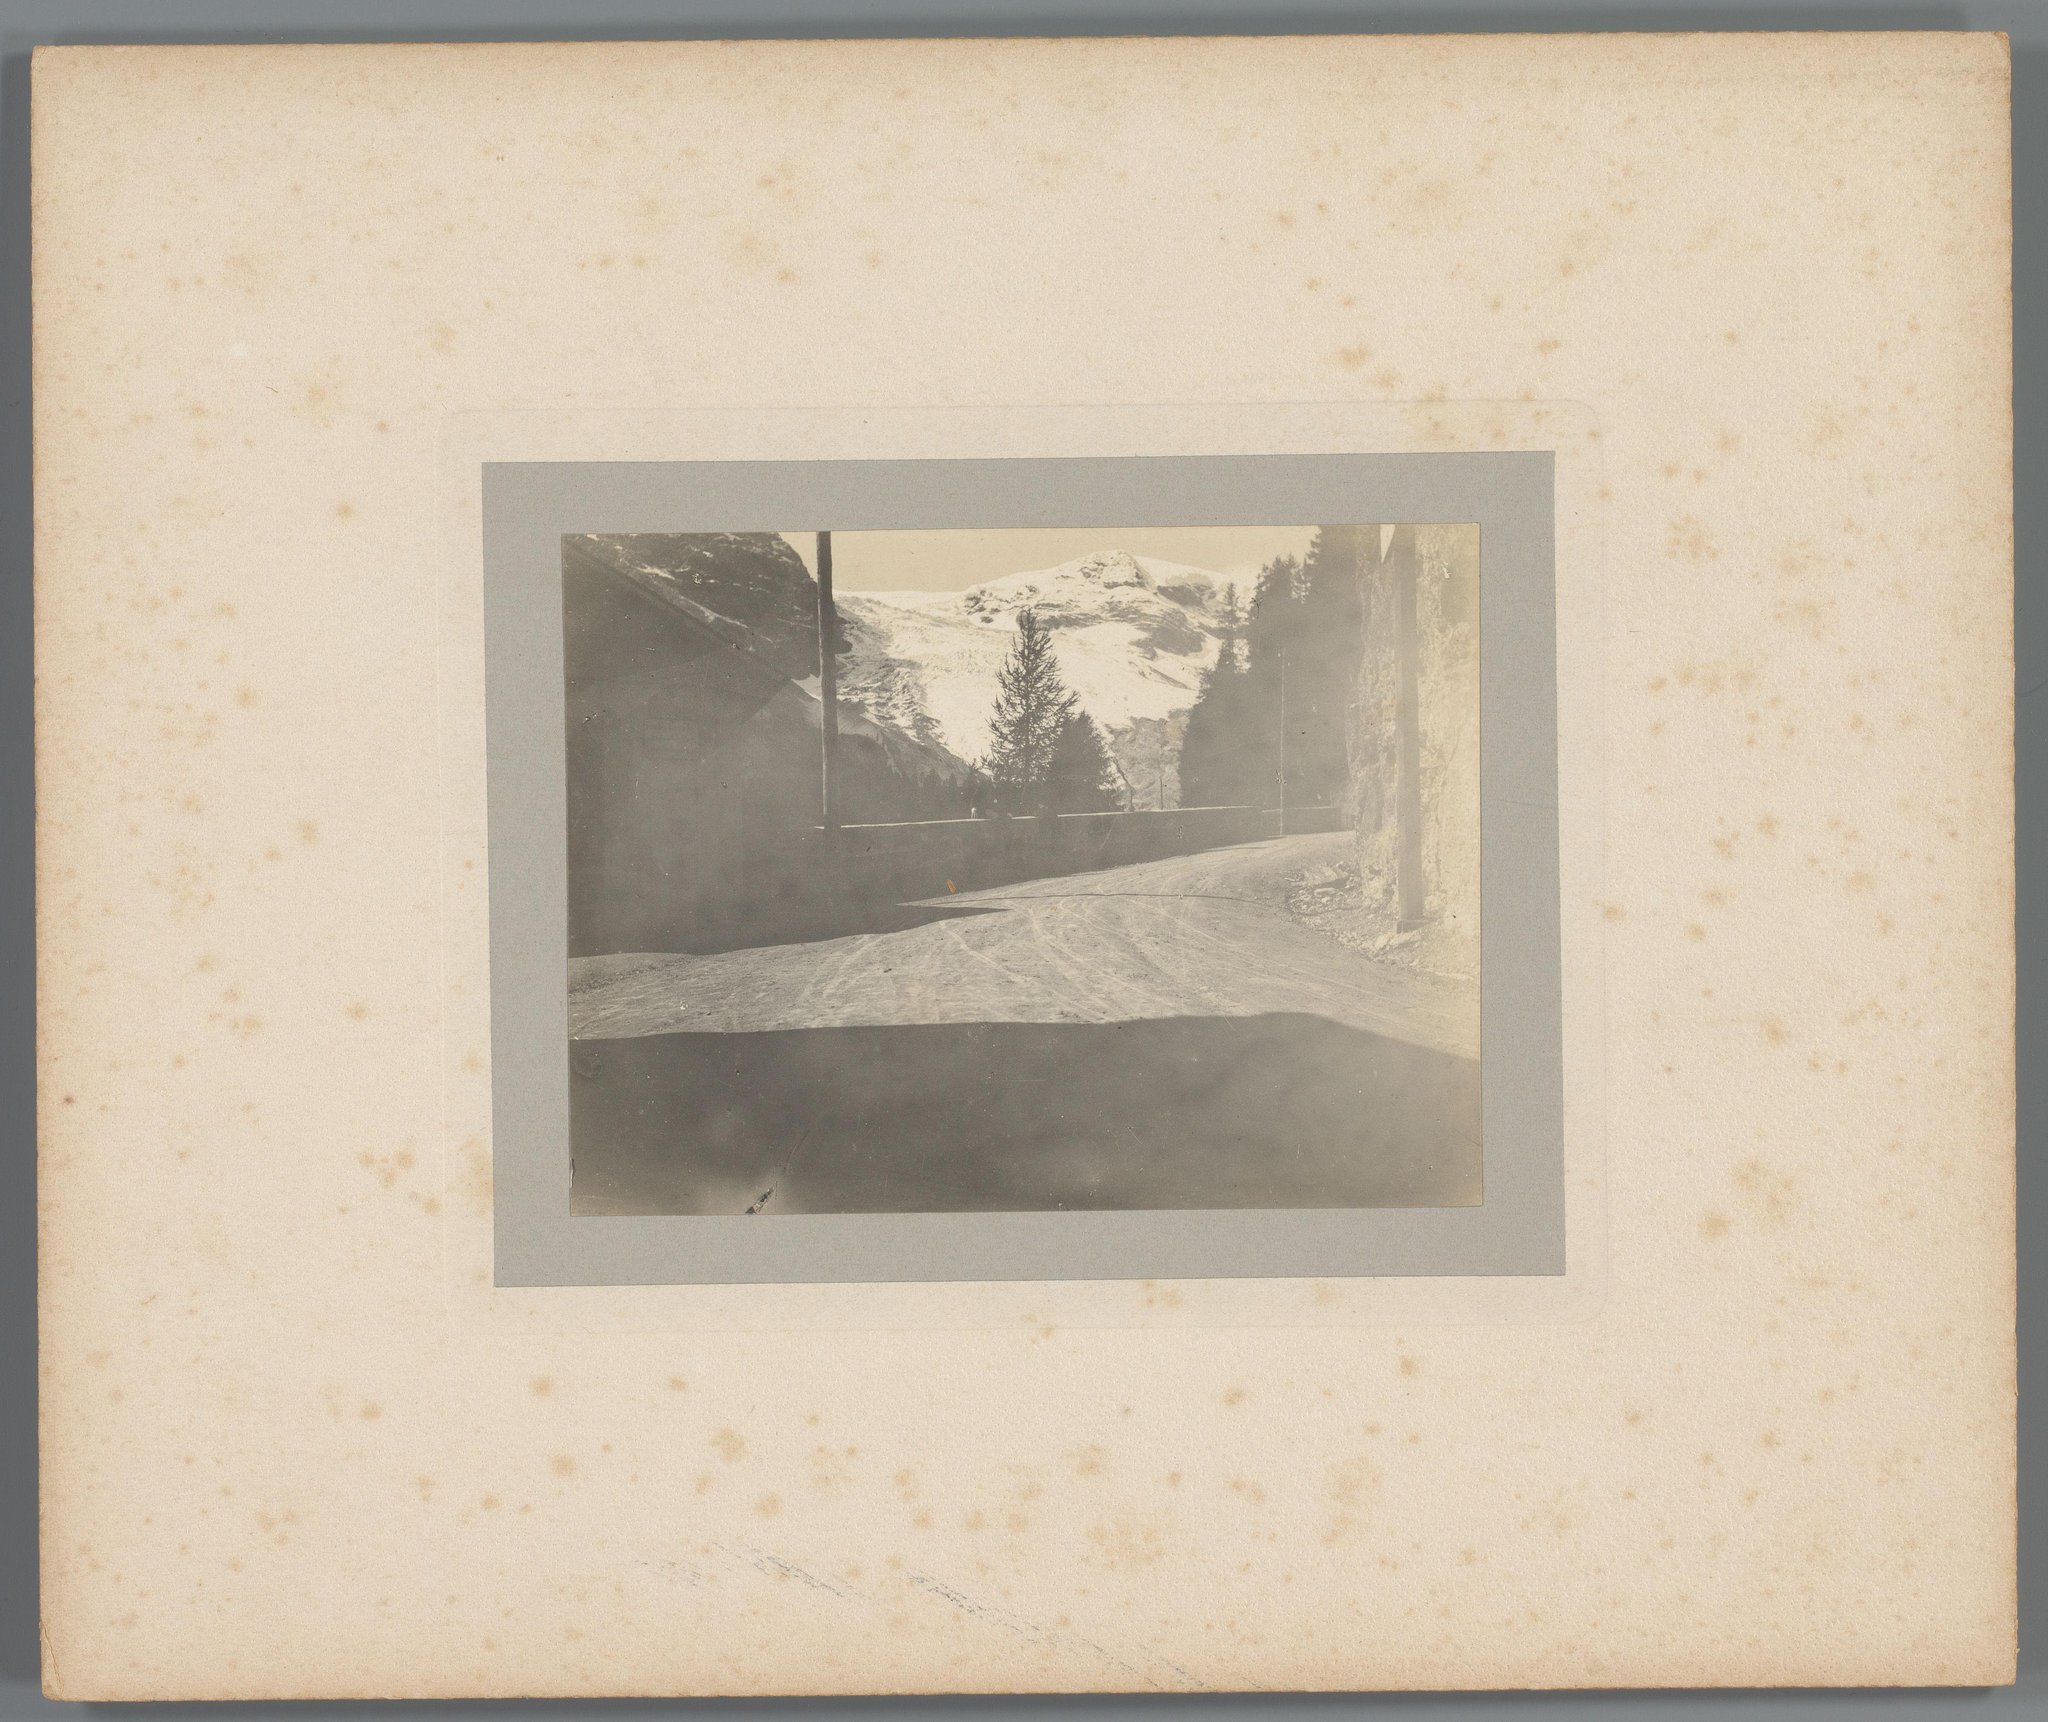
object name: photograph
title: Twee mannen zittend bij een bergweg in de Alpen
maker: françois buys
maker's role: advocaat, amateurfotograaf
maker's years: 1871-1934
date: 1905-1909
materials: paper, cardboard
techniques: gelatin silver print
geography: alps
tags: road, path, mountains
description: Deze foto maakt deel uit van een groep van 38 foto's.